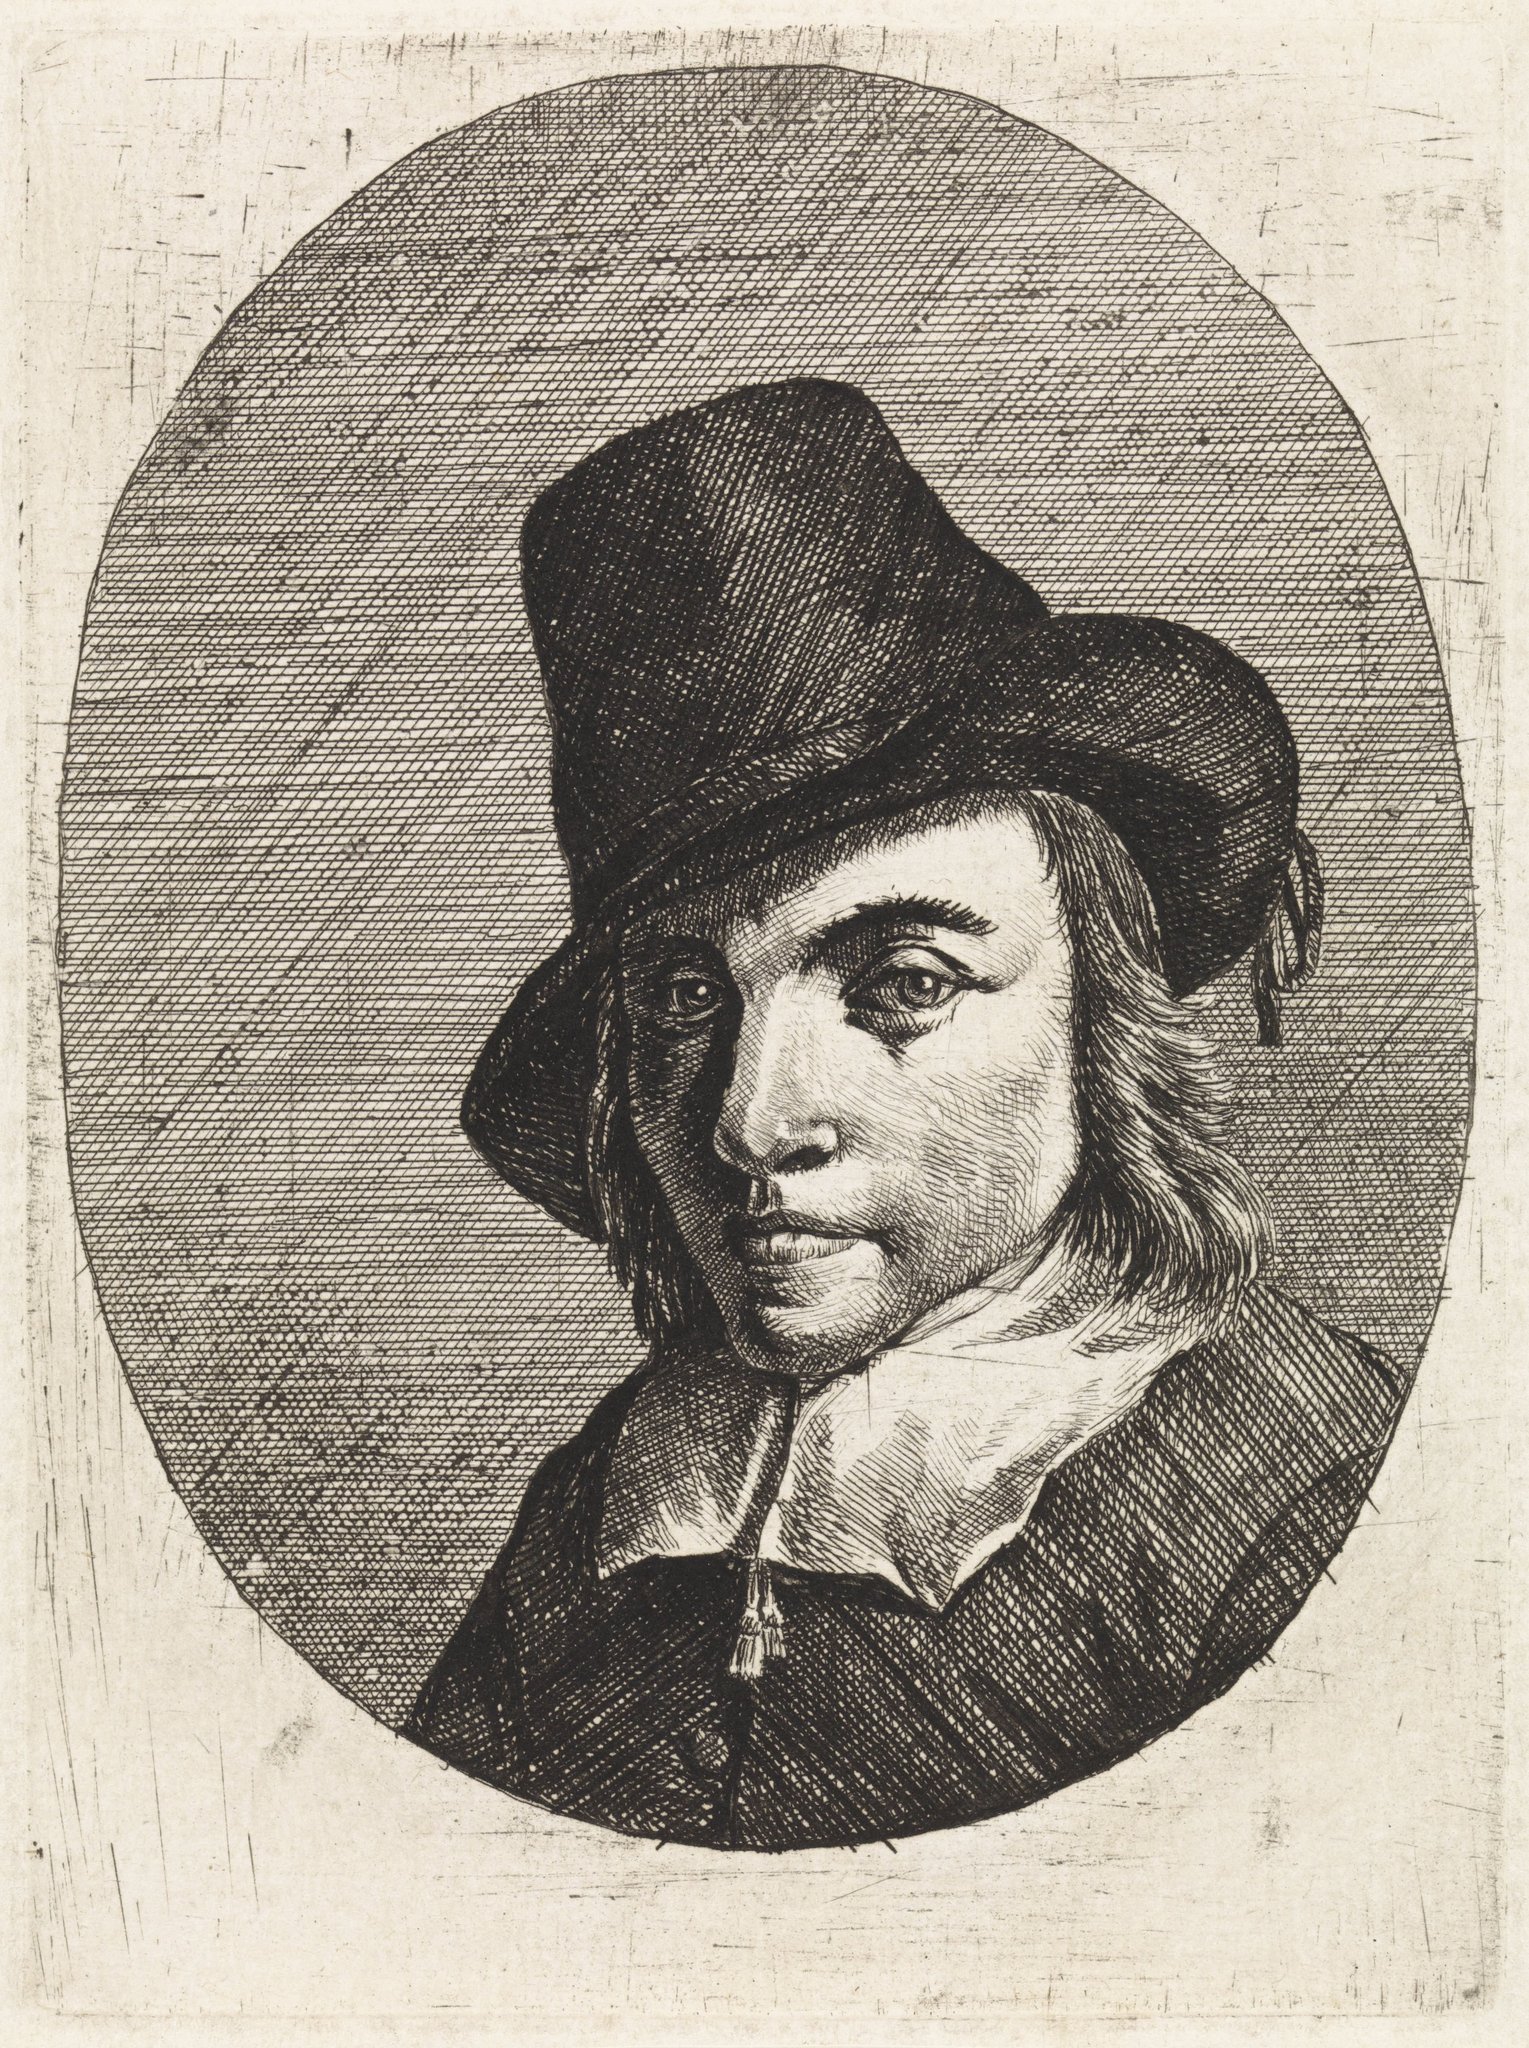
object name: print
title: Portret van een onbekende man met hoed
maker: philippe lambert joseph spruyt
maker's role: print maker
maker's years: 1727-1801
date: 1747-1801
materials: paper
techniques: etching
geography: ghent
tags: adult man, head-gear: hat (+ men's clothes), neck-gear: collar (+ men's clothes)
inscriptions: collector's mark: Lugt 2228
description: Portret van een jongeman met een hoed op het hoofd en een platte witte kraag met twee kwastjes in ovaal.